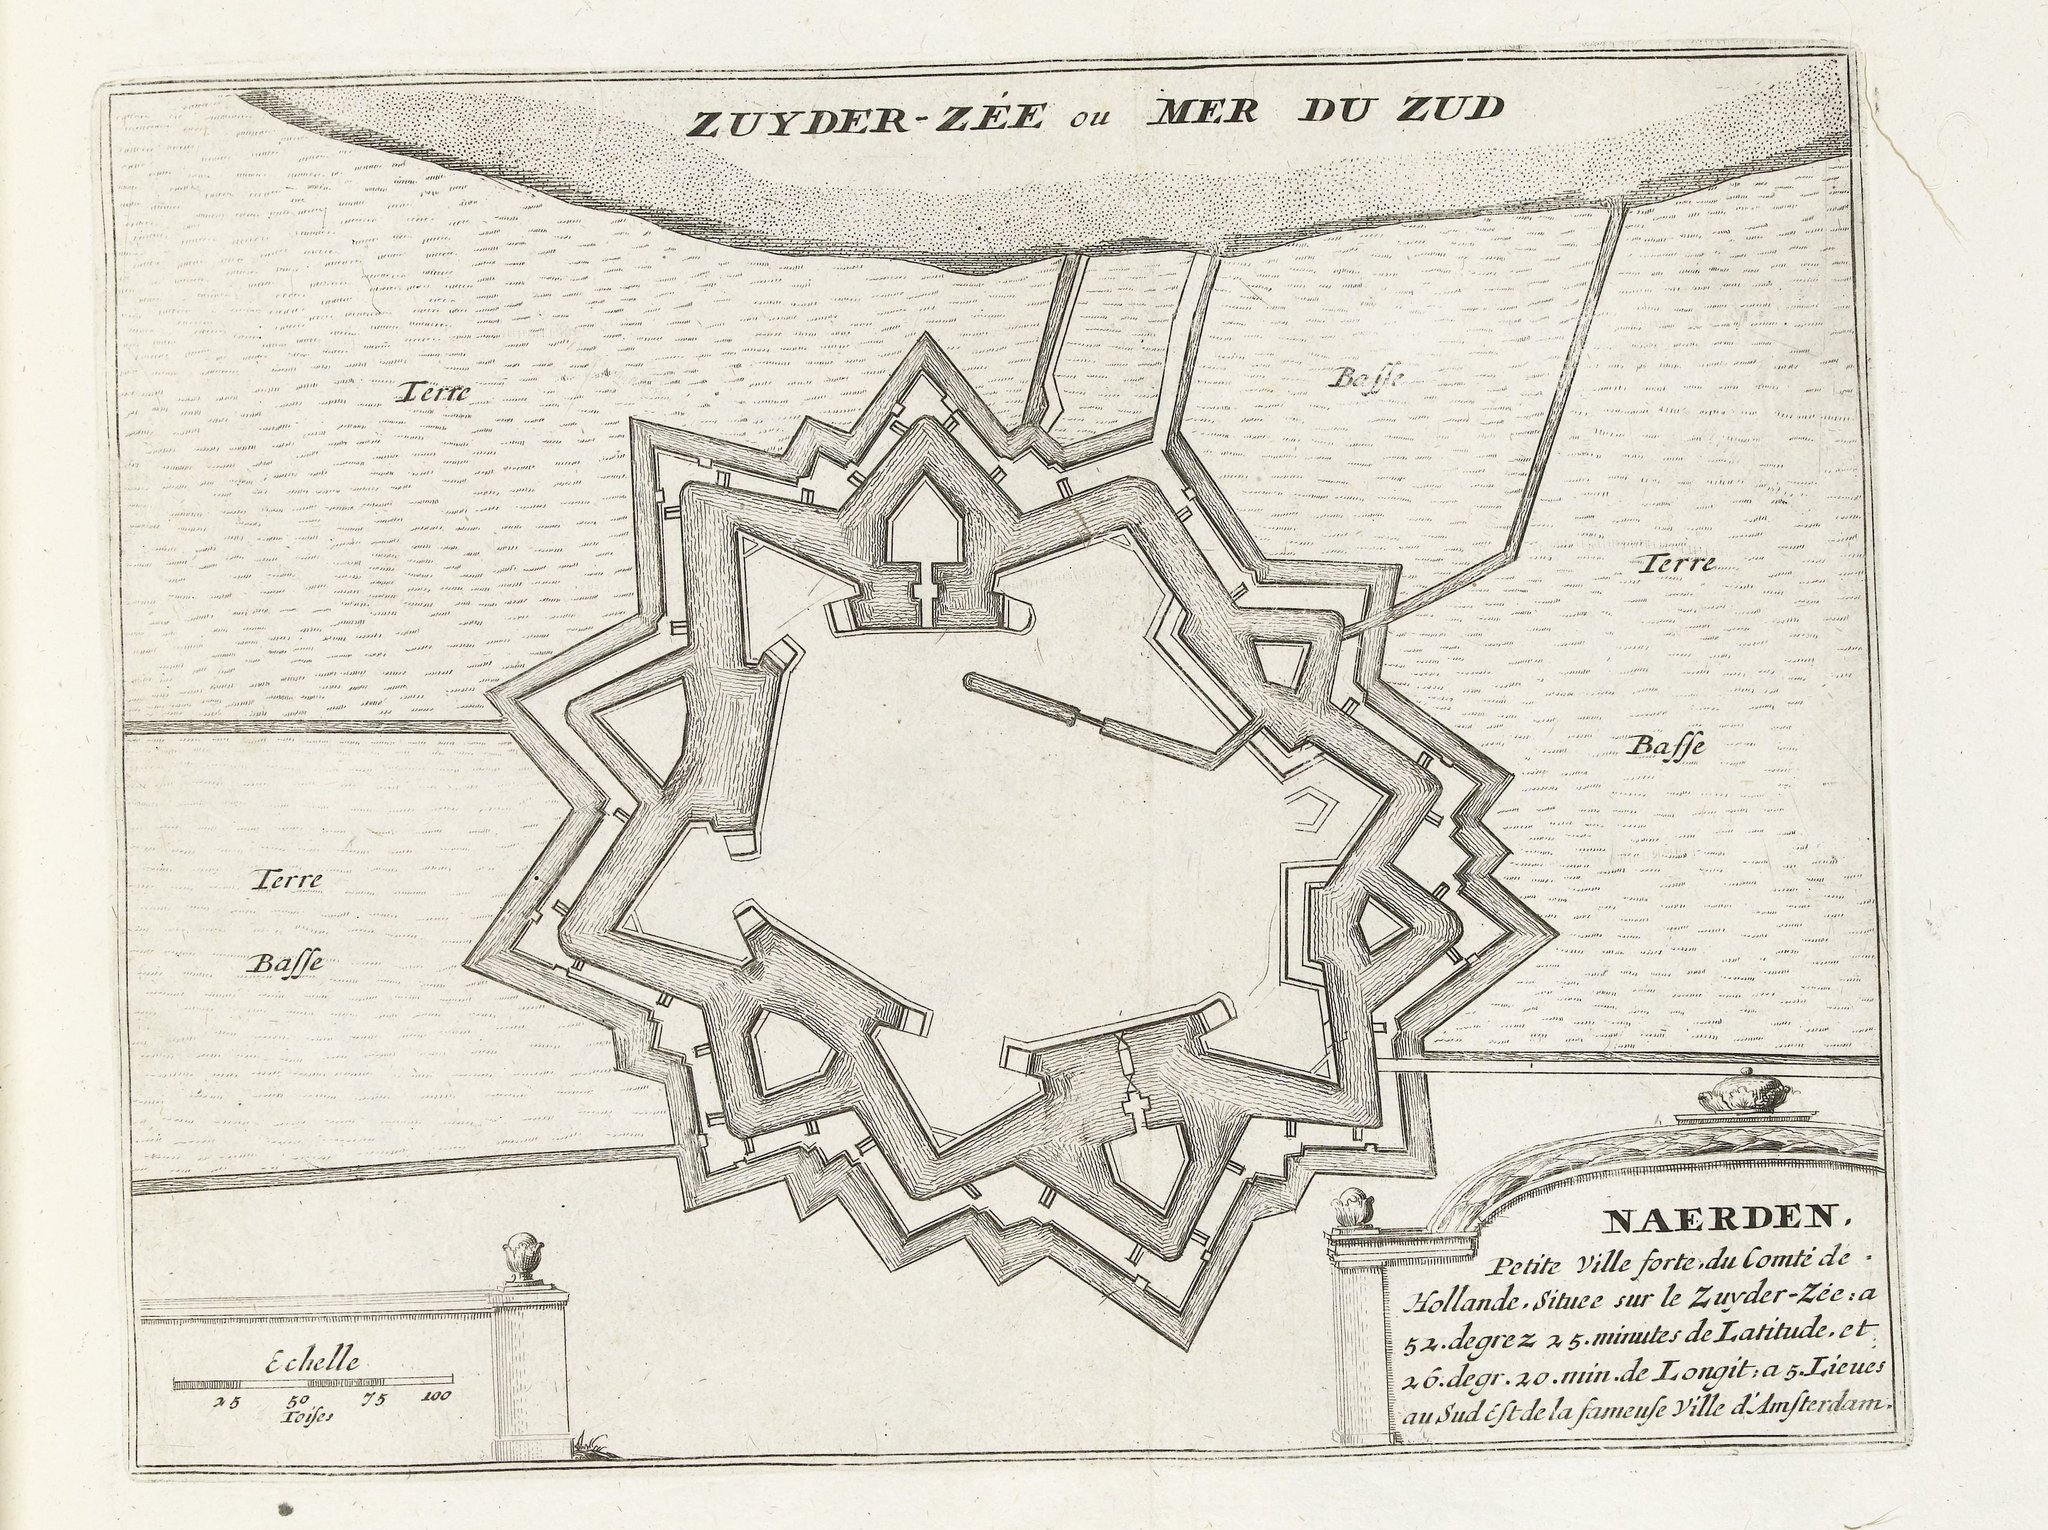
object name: print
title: Plattegrond van Naarden, ca. 1693-1695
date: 1693-1695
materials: paper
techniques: engraving, etching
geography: france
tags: fortress, maps of cities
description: Plattegrond van de versterkingen om de Hollandse stad Naarden. Onderdeel van het derde deel (1695) van het prentwerk waarin gebundeld zijn de acht delen van Les forces de l'Europe uitgegeven tussen 1693-1697. Het prentwerk bestaat uit 175 platen met plannen (afkomstig van Sébastien Le Prestre, Seigneur de Vauban) van vermaarde sterke steden en vestingen in de Negenjarige Oorlog. Titel en opschriften in het Frans.